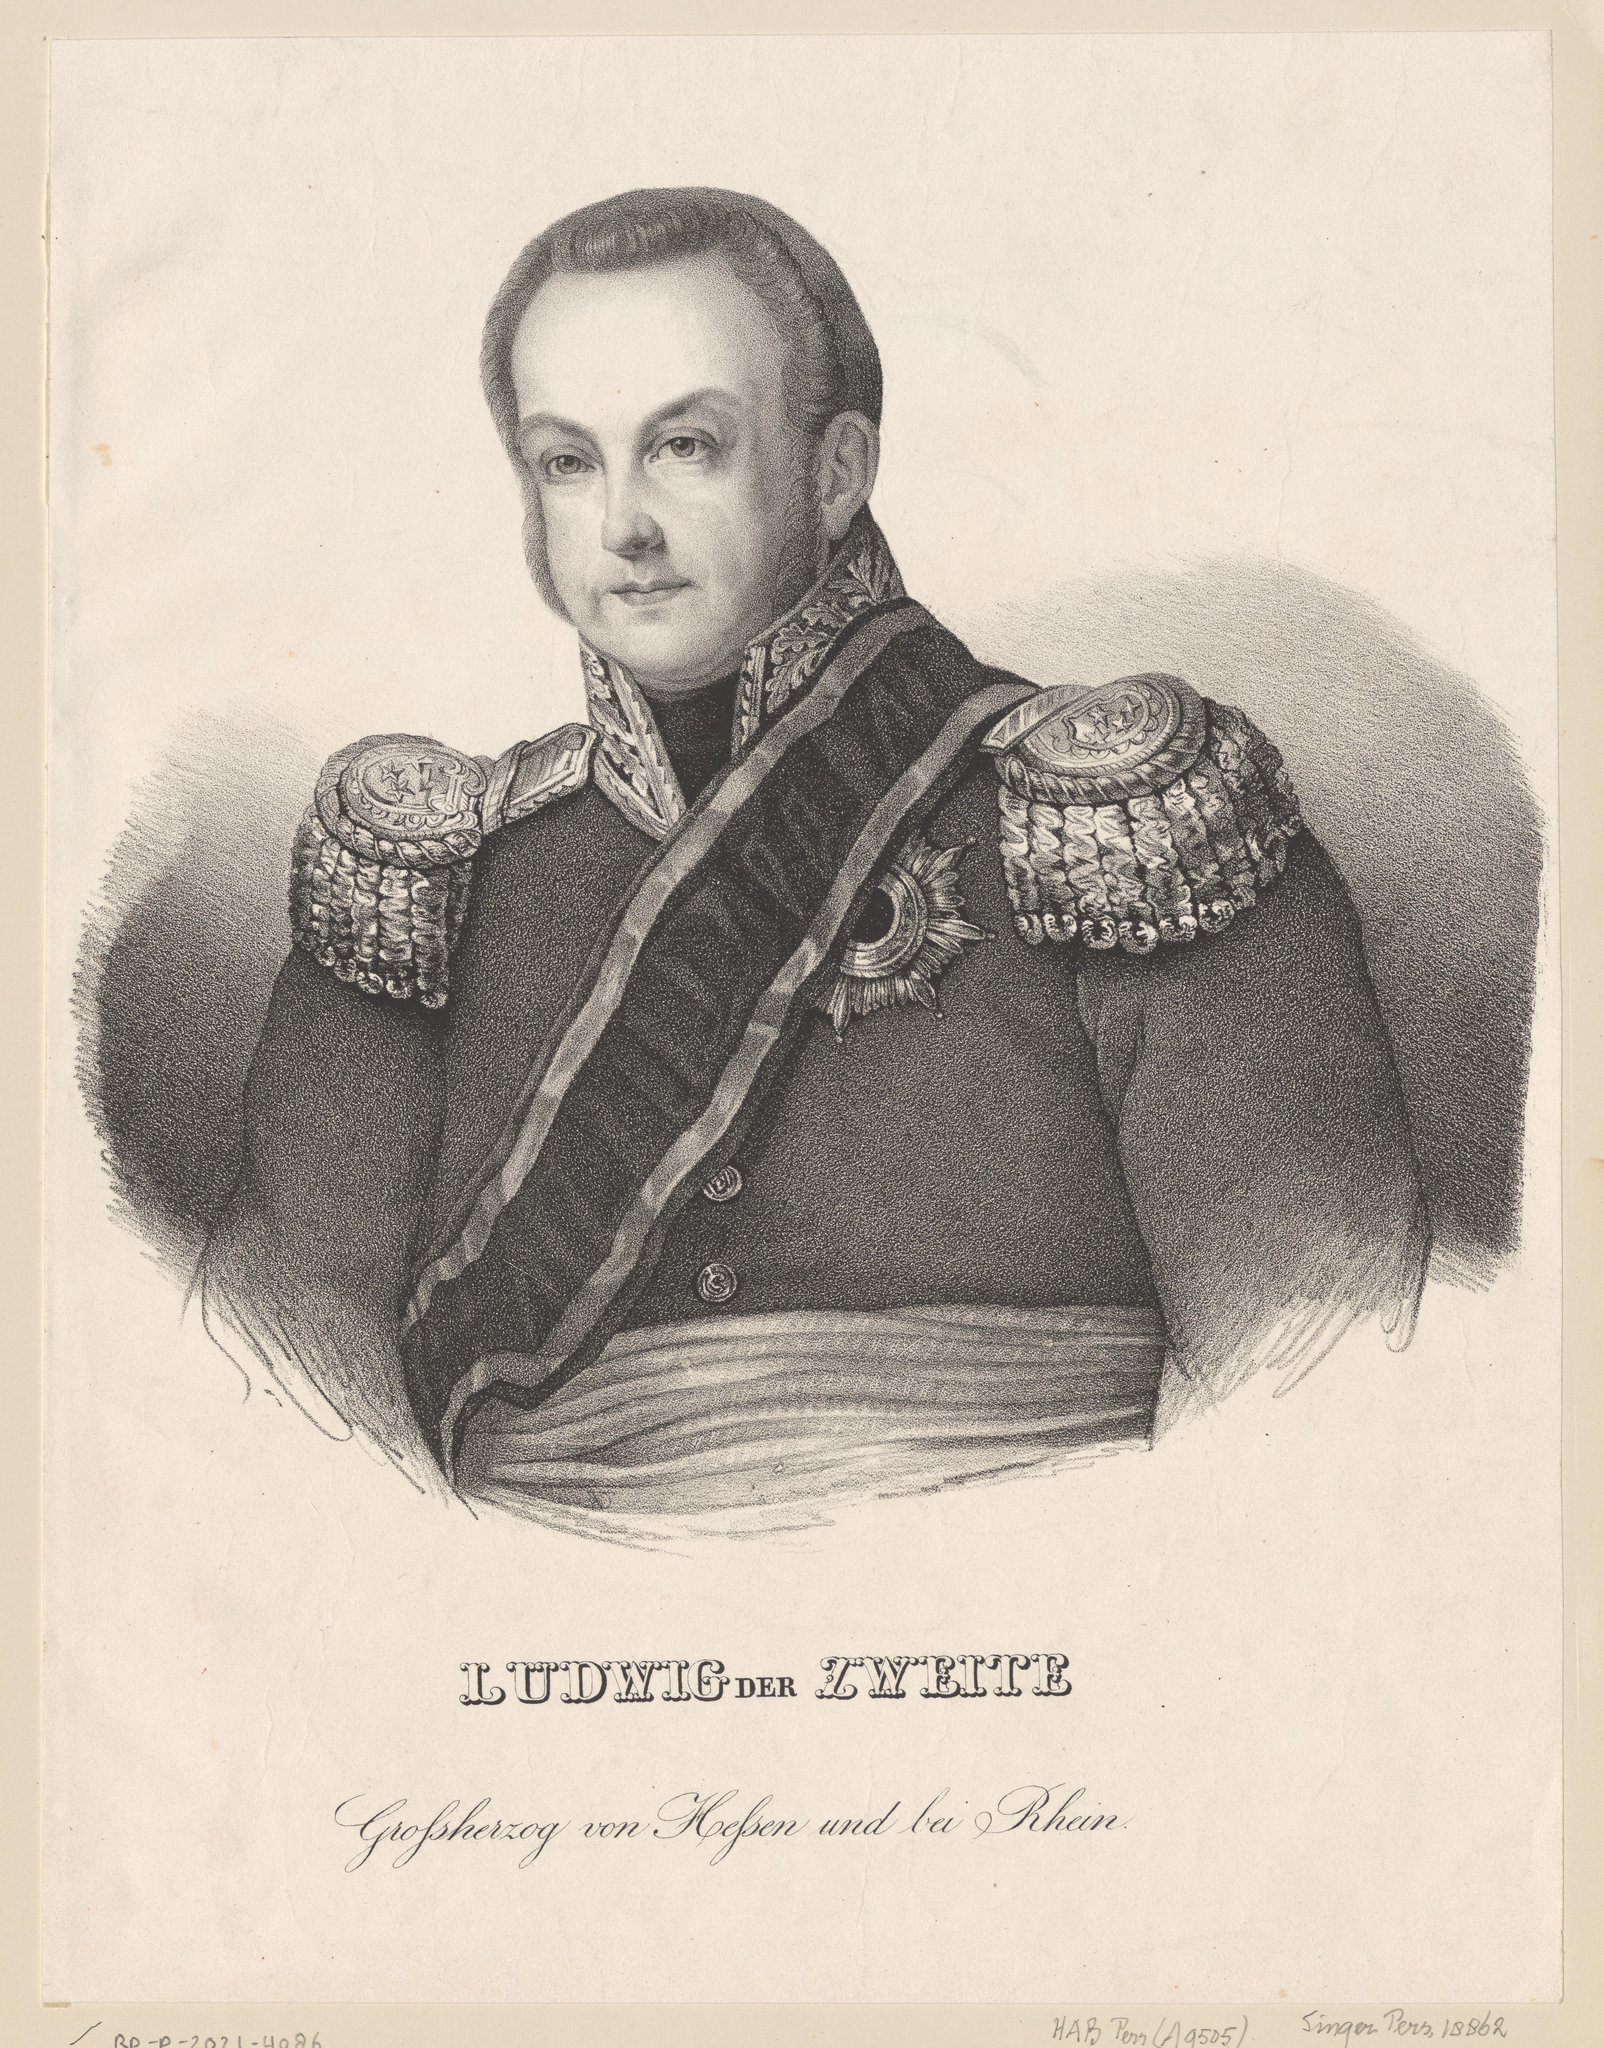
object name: print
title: Portret van Lodewijk II van Hessen-Darmstadt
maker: Anonymous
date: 1830-1880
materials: paper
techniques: lithograph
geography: germany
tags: historical persons, (military) uniforms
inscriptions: collector's mark: Lugt 2228